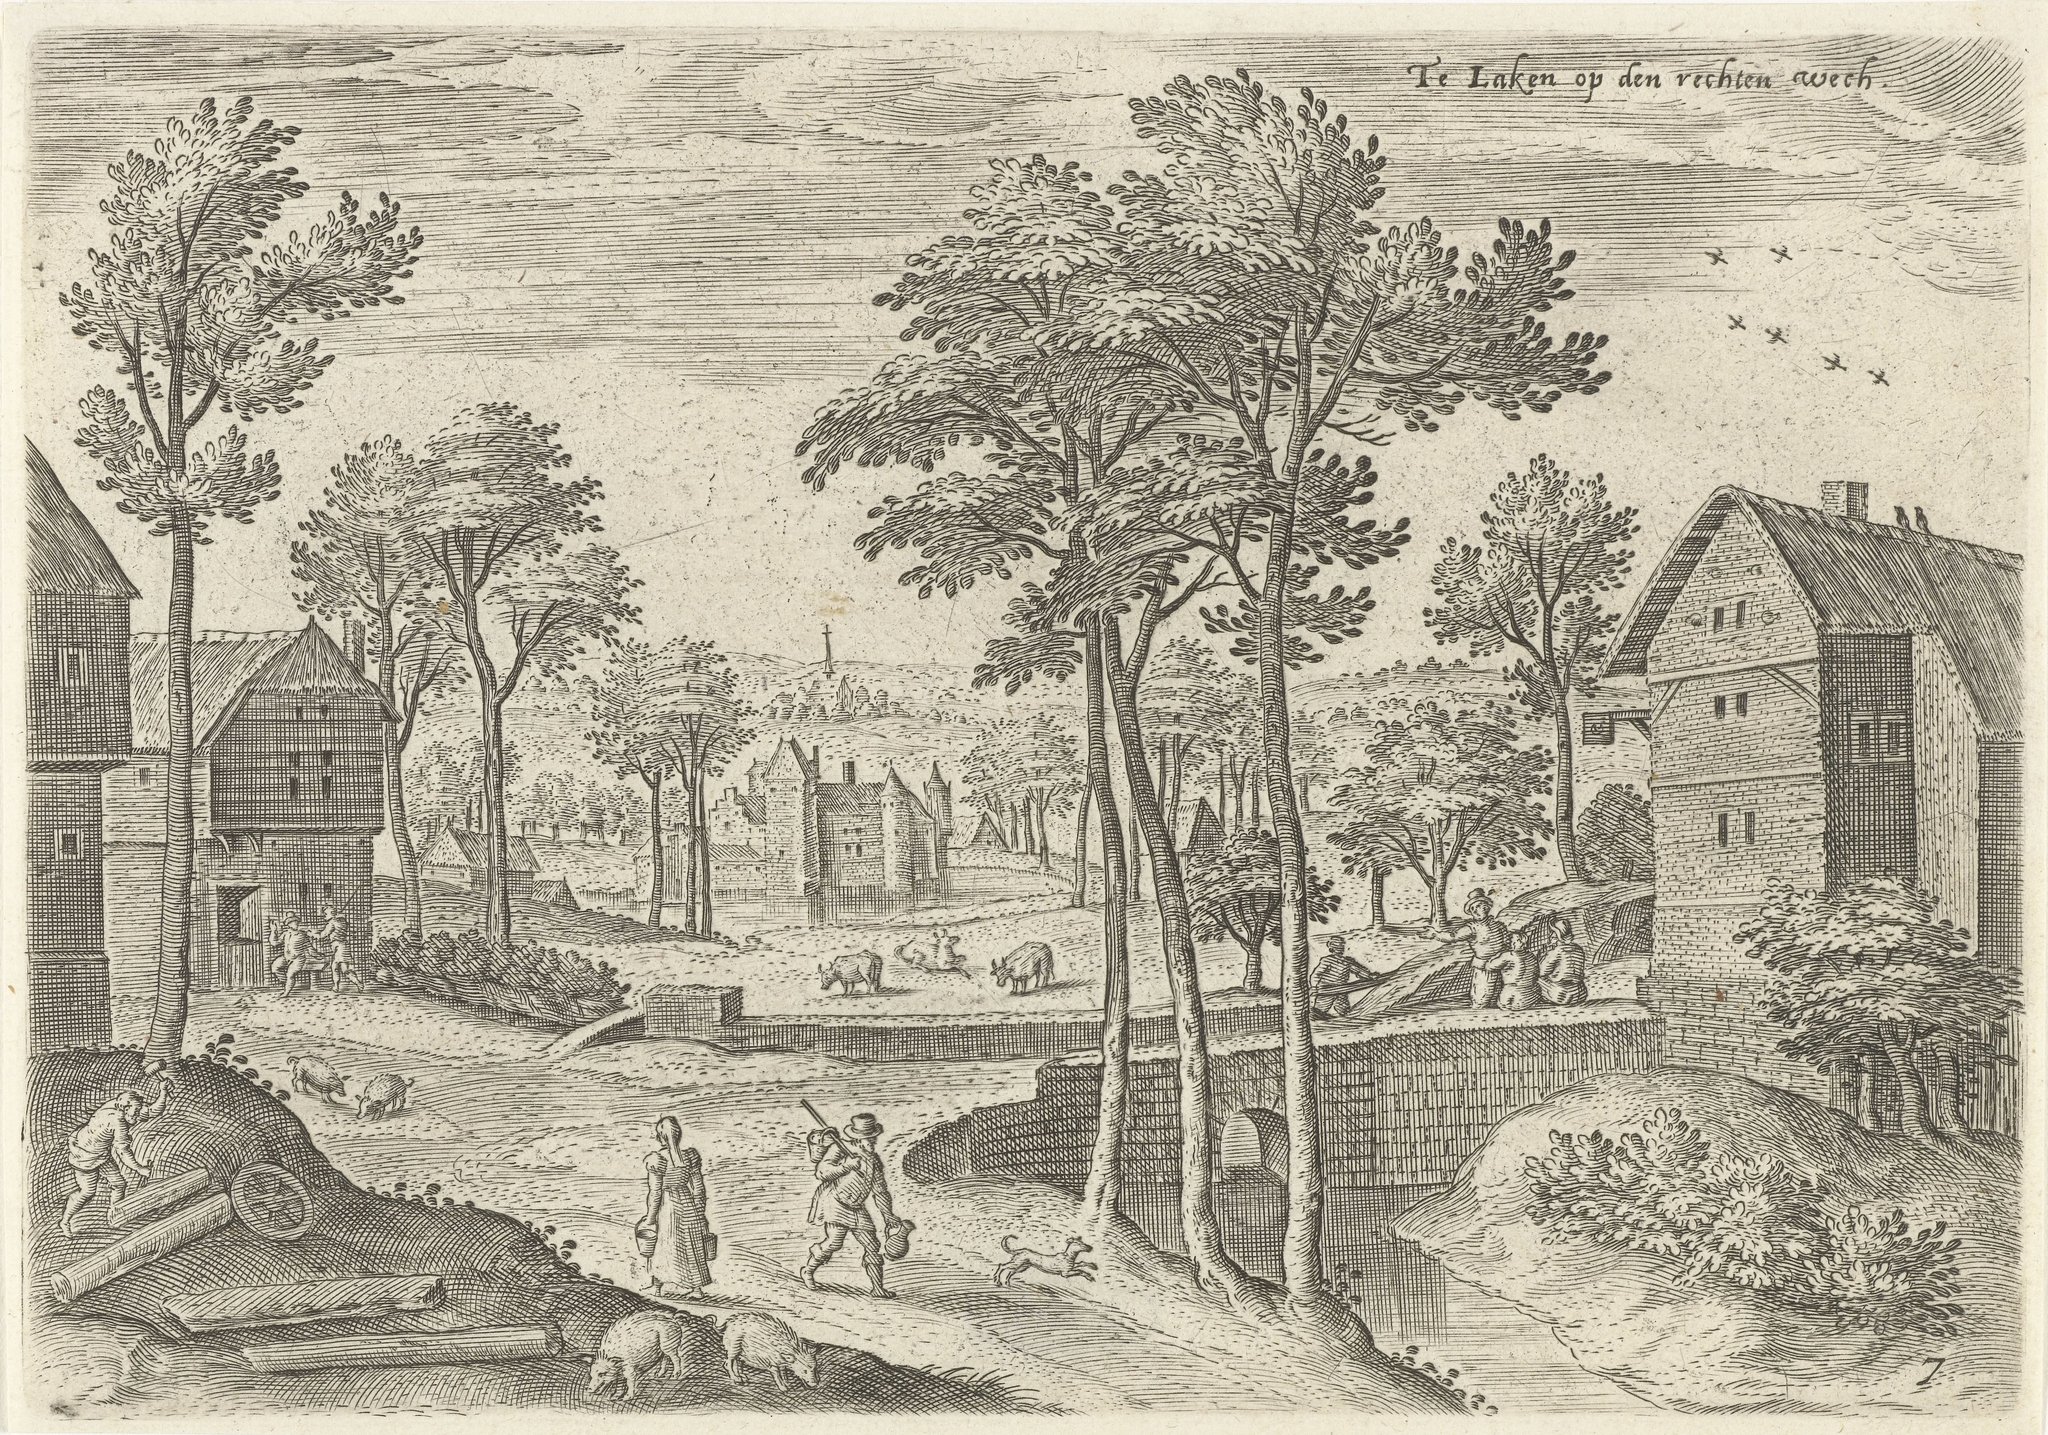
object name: print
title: Te Laken op den rechten wech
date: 1530-1580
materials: paper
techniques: engraving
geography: antwerp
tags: public road in village (+ city(-scape) with figures, staffage), laeken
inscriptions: collector's mark: Lugt 2228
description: Gezicht op de hoofdweg van Laken, een dorp vlakbij Brussel. Op de weg enkele wandelaars. De prent is deel van een serie met gezichten uit de omgeving van Brussel.